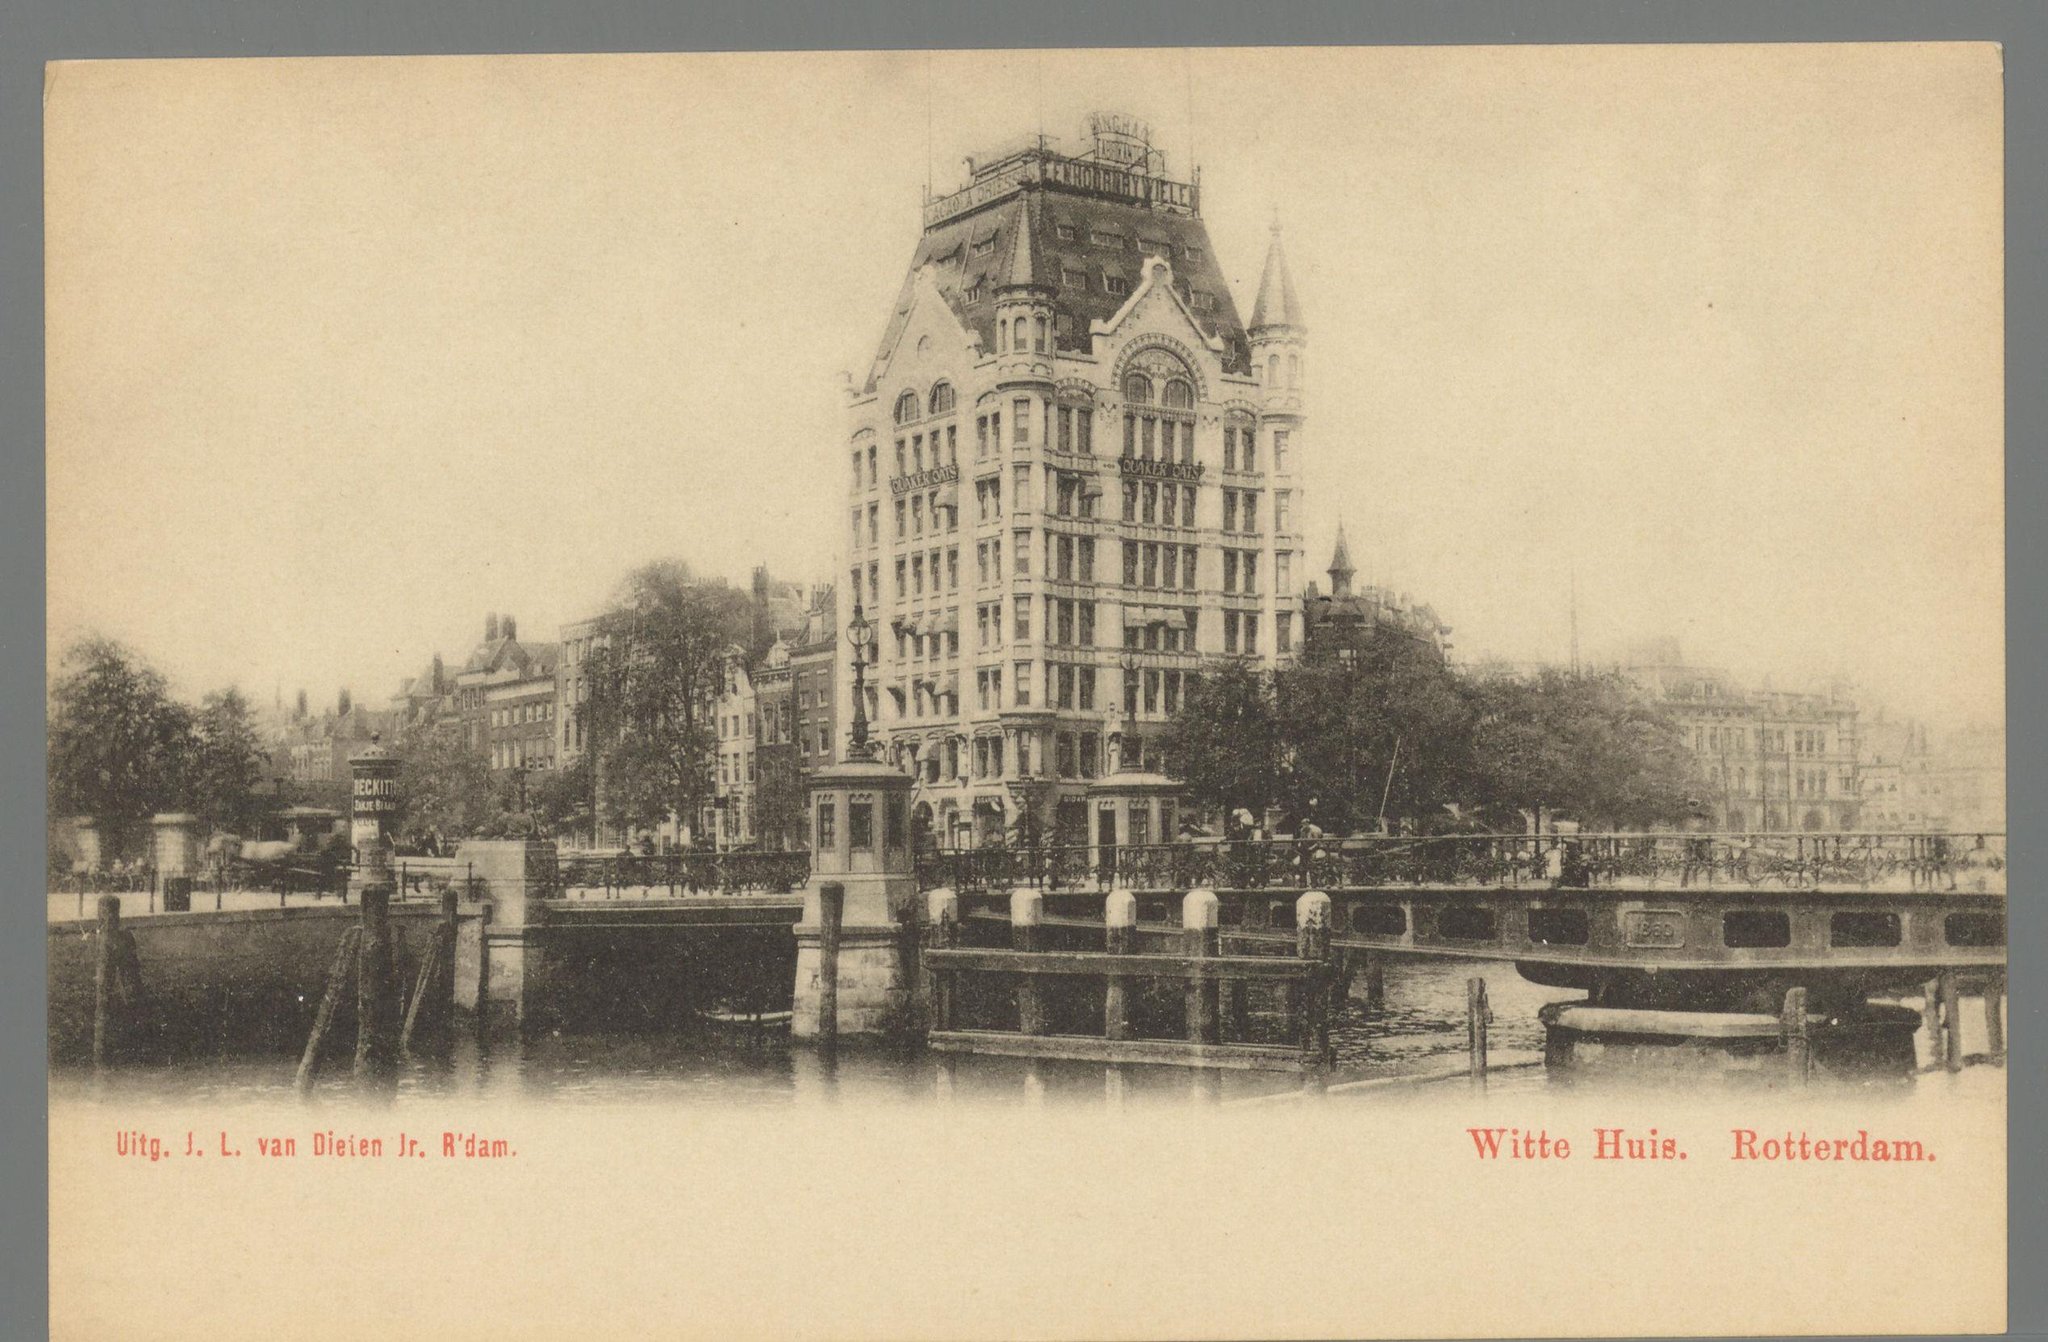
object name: photomechanical print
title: Witte Huis. Rotterdam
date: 1897-1905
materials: cardboard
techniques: photograph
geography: rotterdam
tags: skyscraper, river, bridge in city across river, canal, etc.